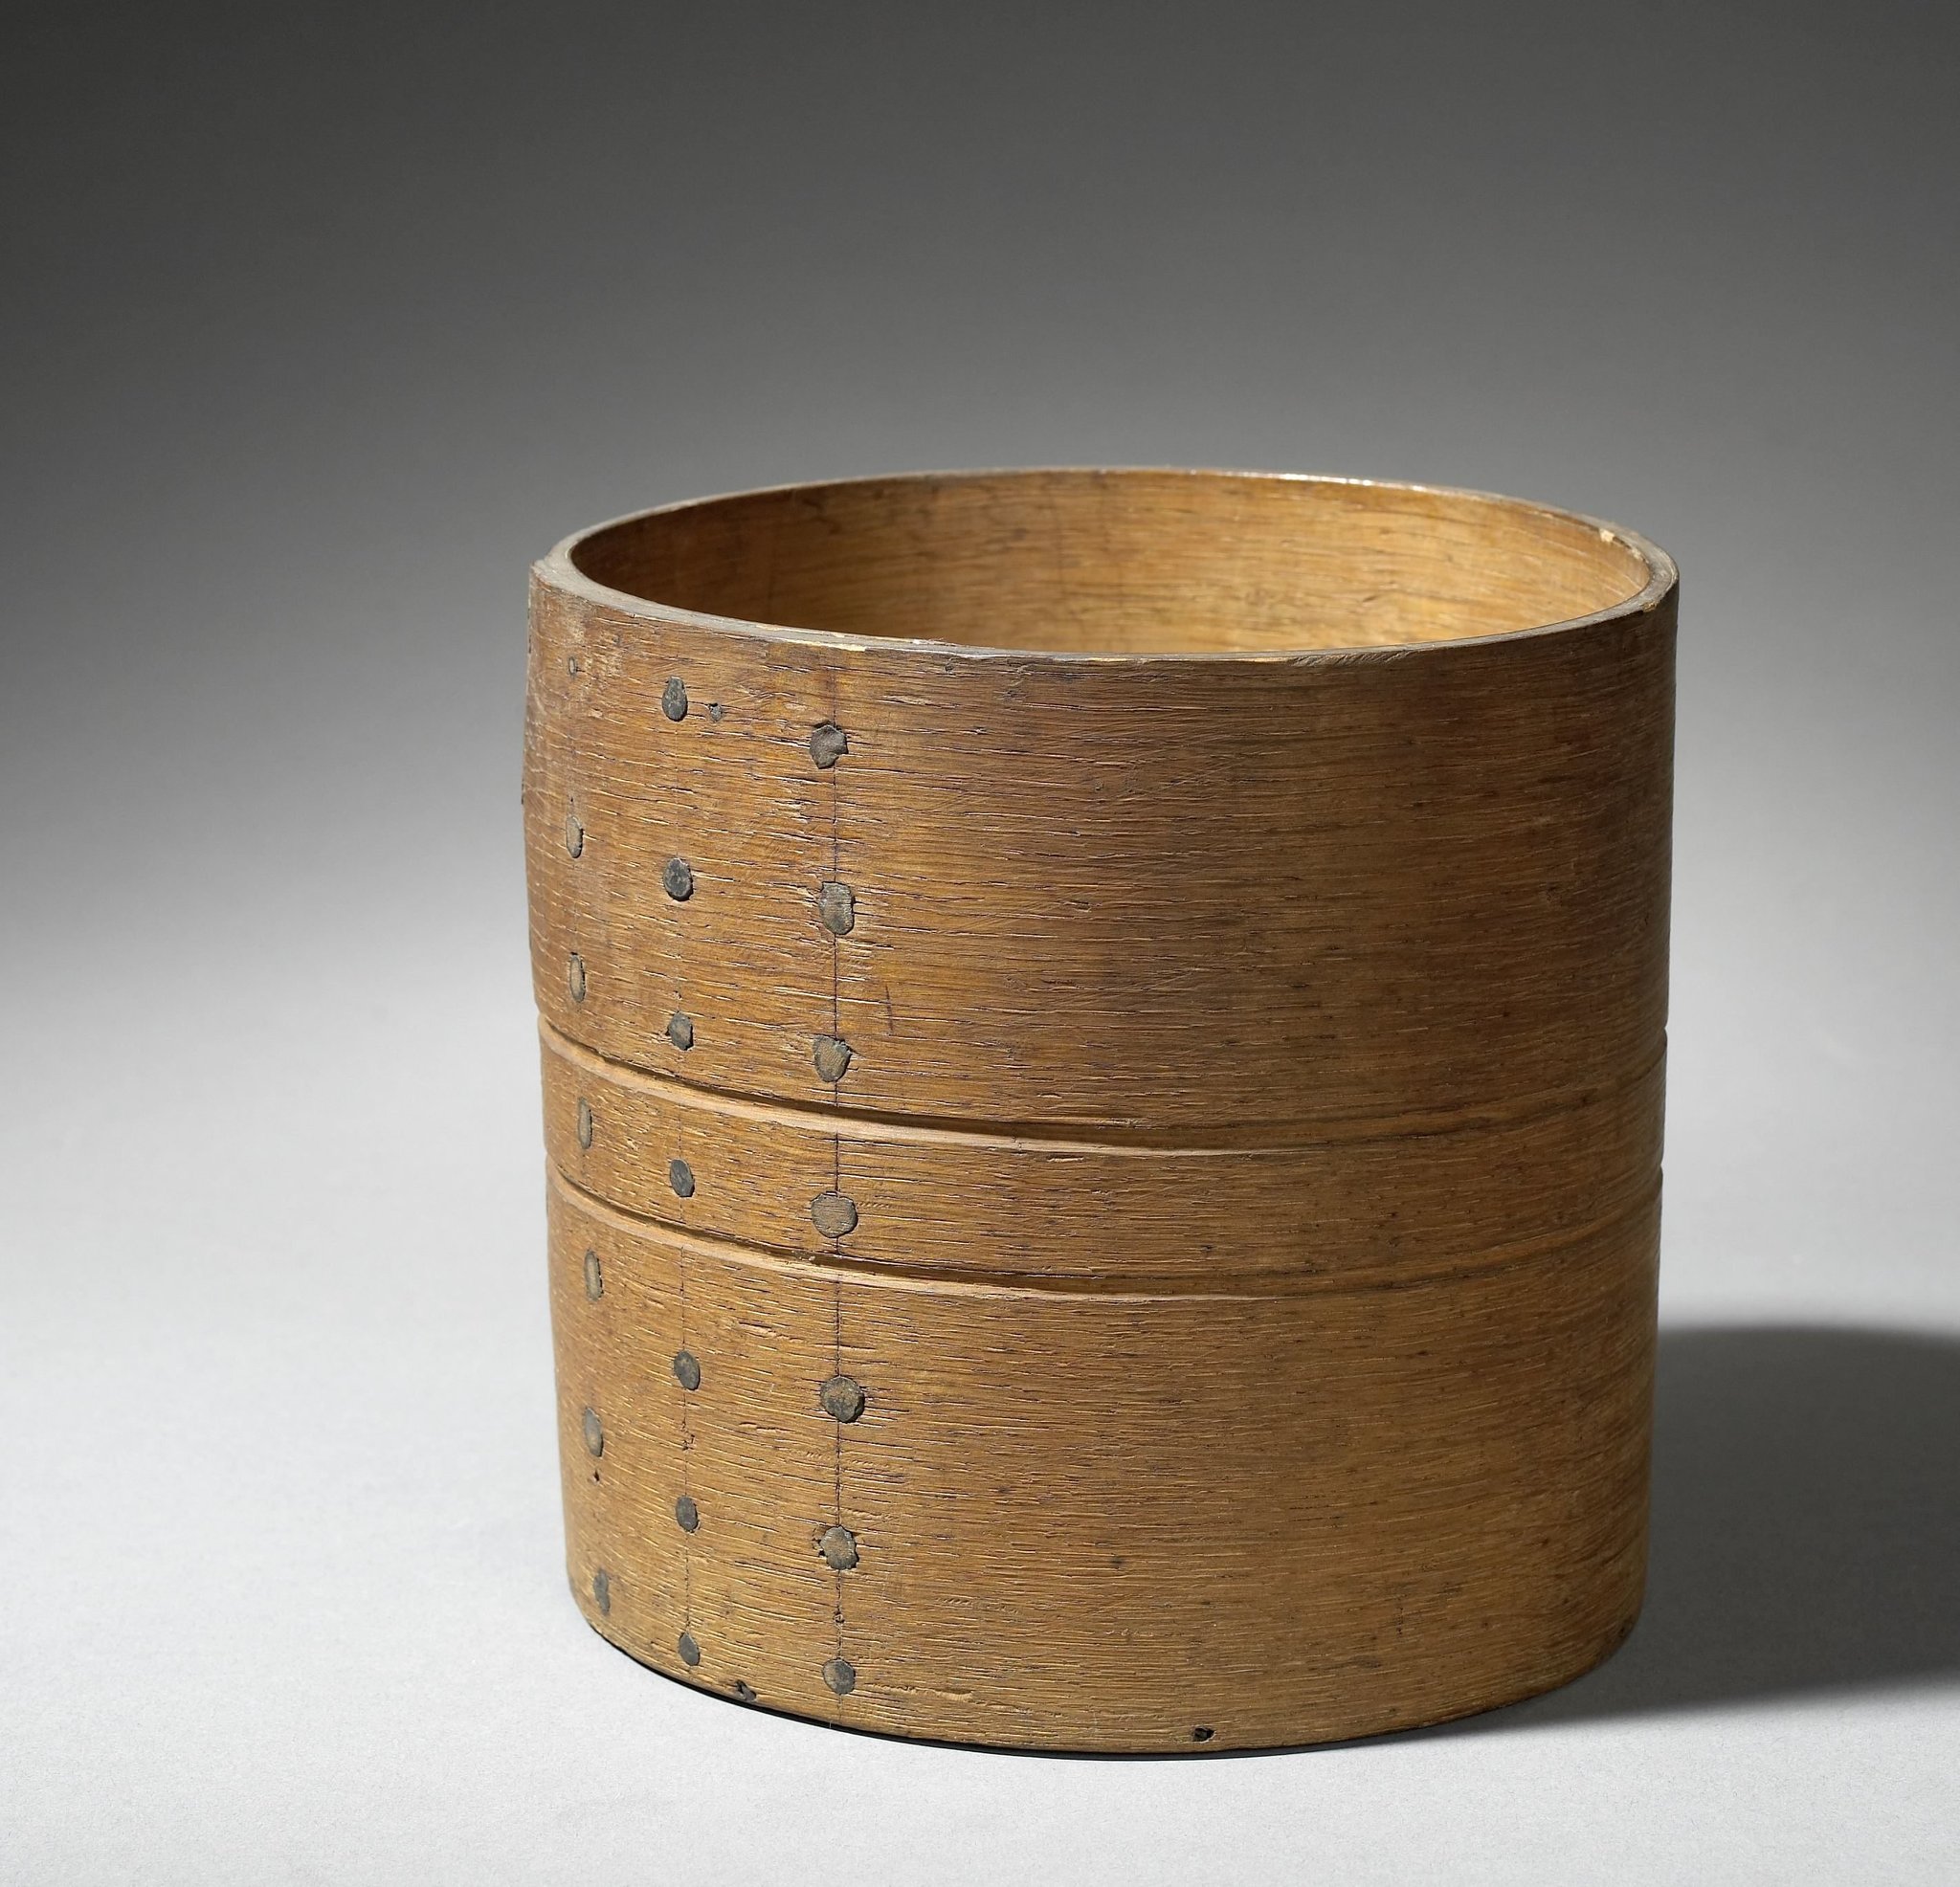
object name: graanmaat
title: Graanmaat van 2 liter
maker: Anonymous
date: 1803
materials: wood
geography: netherlands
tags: netherlands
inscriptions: title: ‘Double litre a grain 1803’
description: Houten graanmaat van 2 liter met etiket.